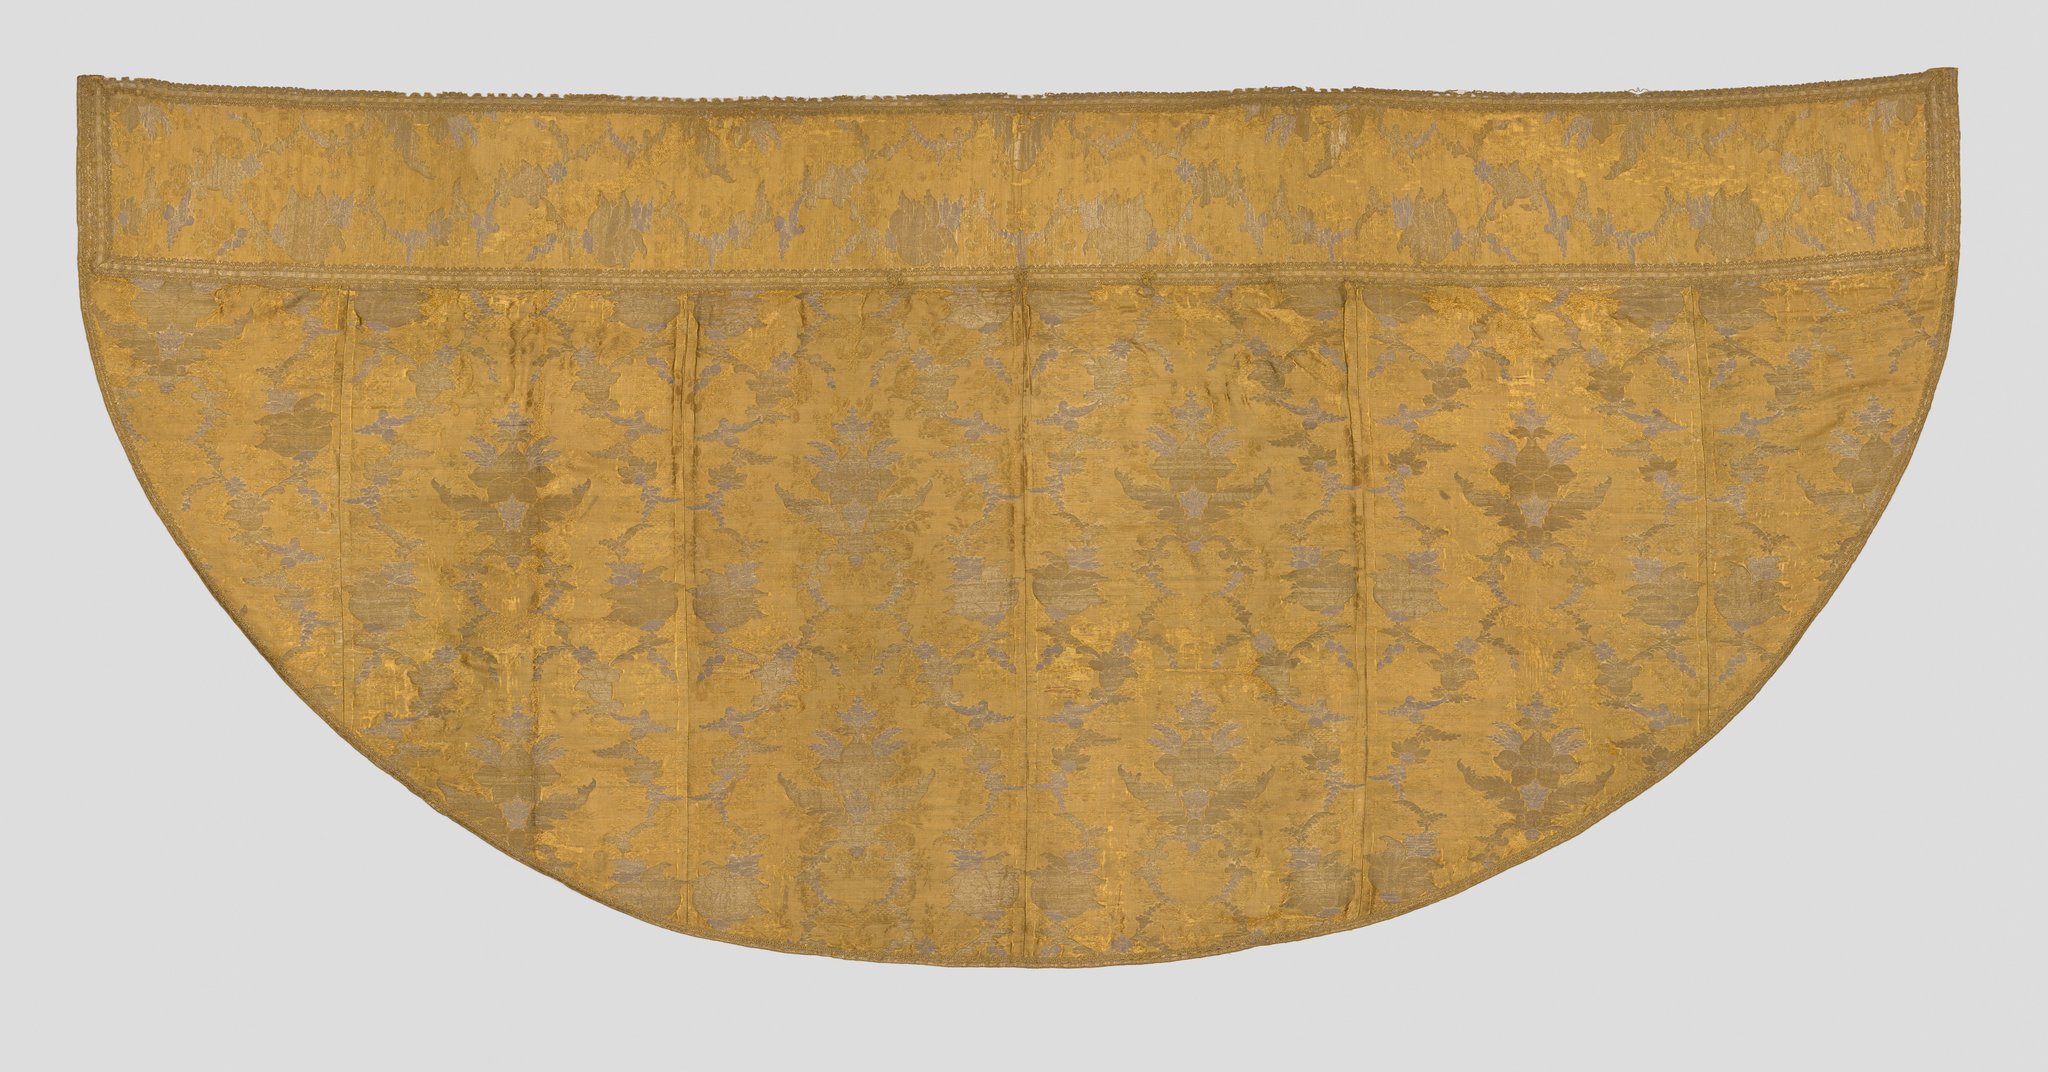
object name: cope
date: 1650-1700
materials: metal thread, silk, silver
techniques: dyeing